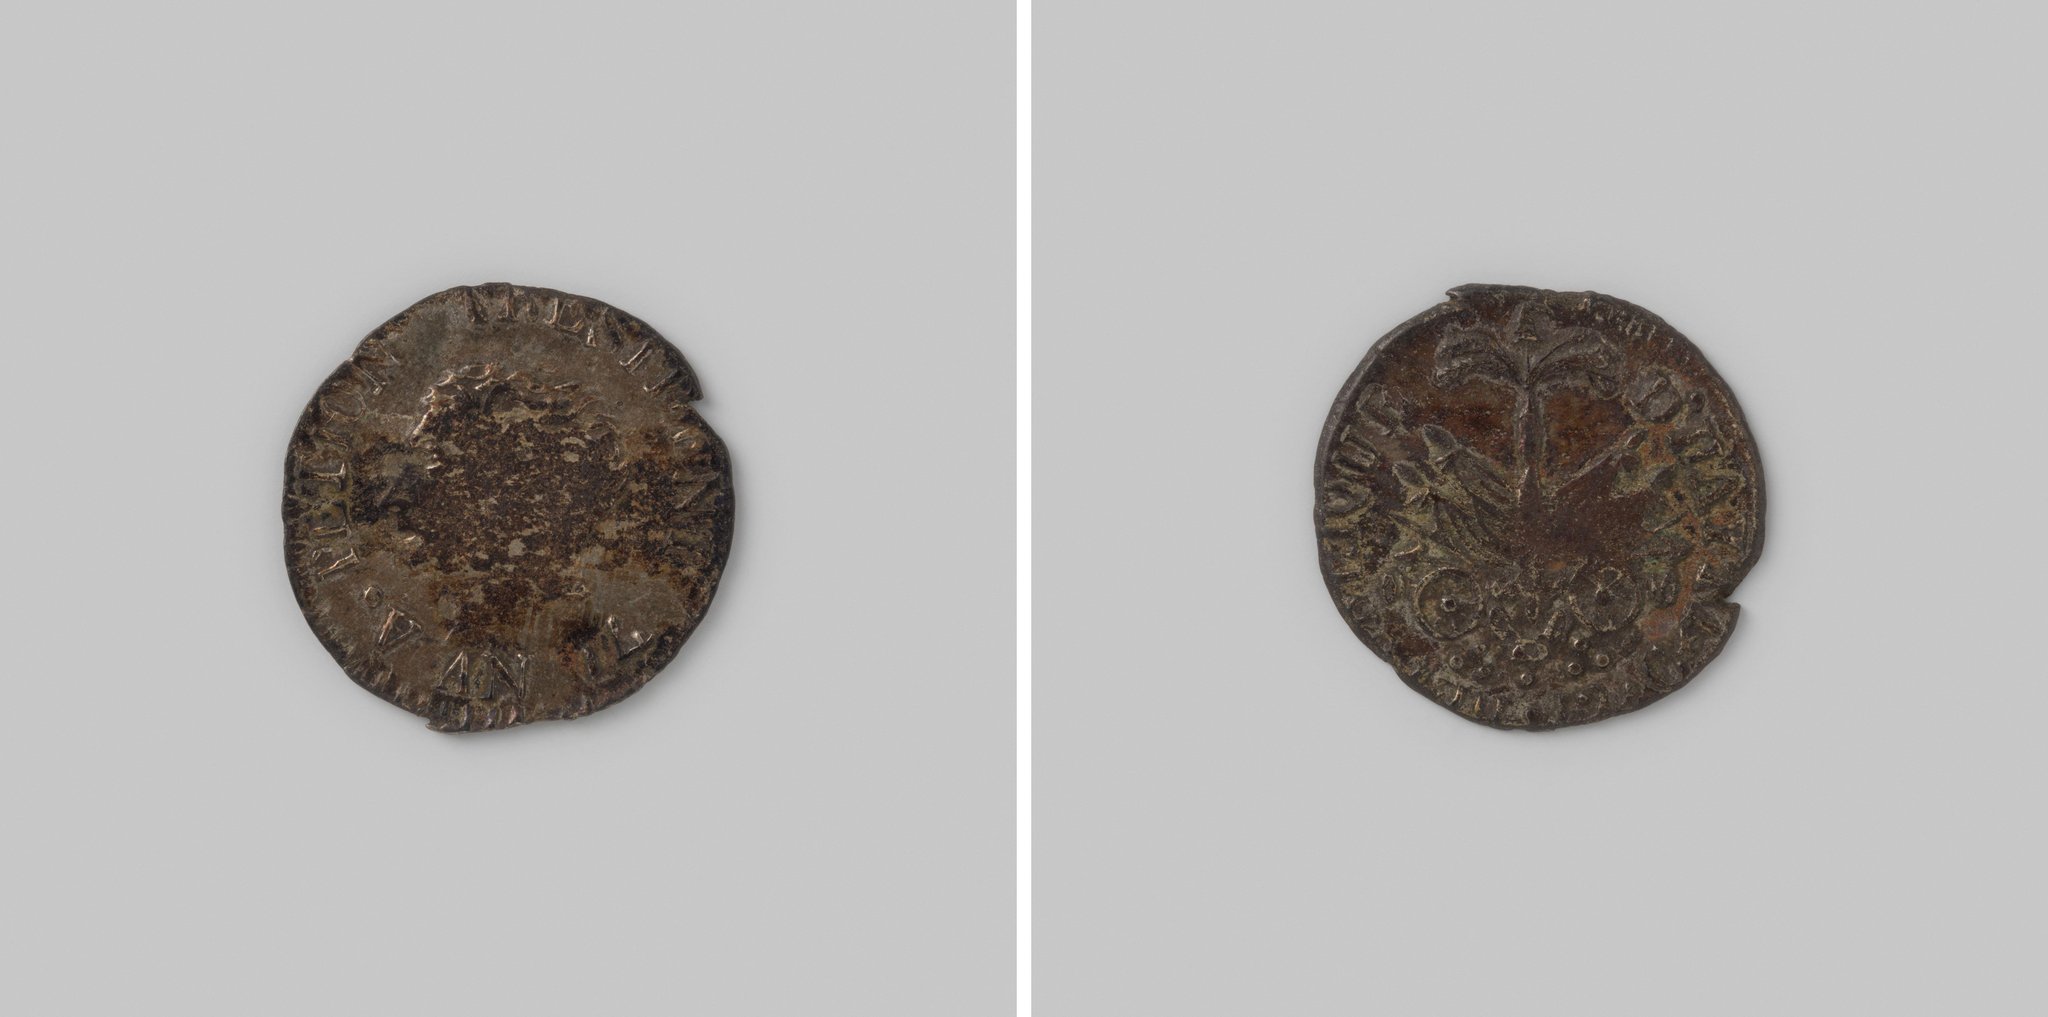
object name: coin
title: Haïti, Alexandre Pétion, 12 centimes of reaal, 1817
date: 1817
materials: silver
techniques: striking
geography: haiti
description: Zilveren munt. Voorzijde: hoofd van de president naar links. Onderaan jaartal: AN 14. Keerzijde: uit trommel oprijzende palmboom, waarachter banieren. links en rechts van trommel twee kanonnen, waaronder stapel kogels. Onderaan waarde-aanduiding: 12 C.. Gladde rand.